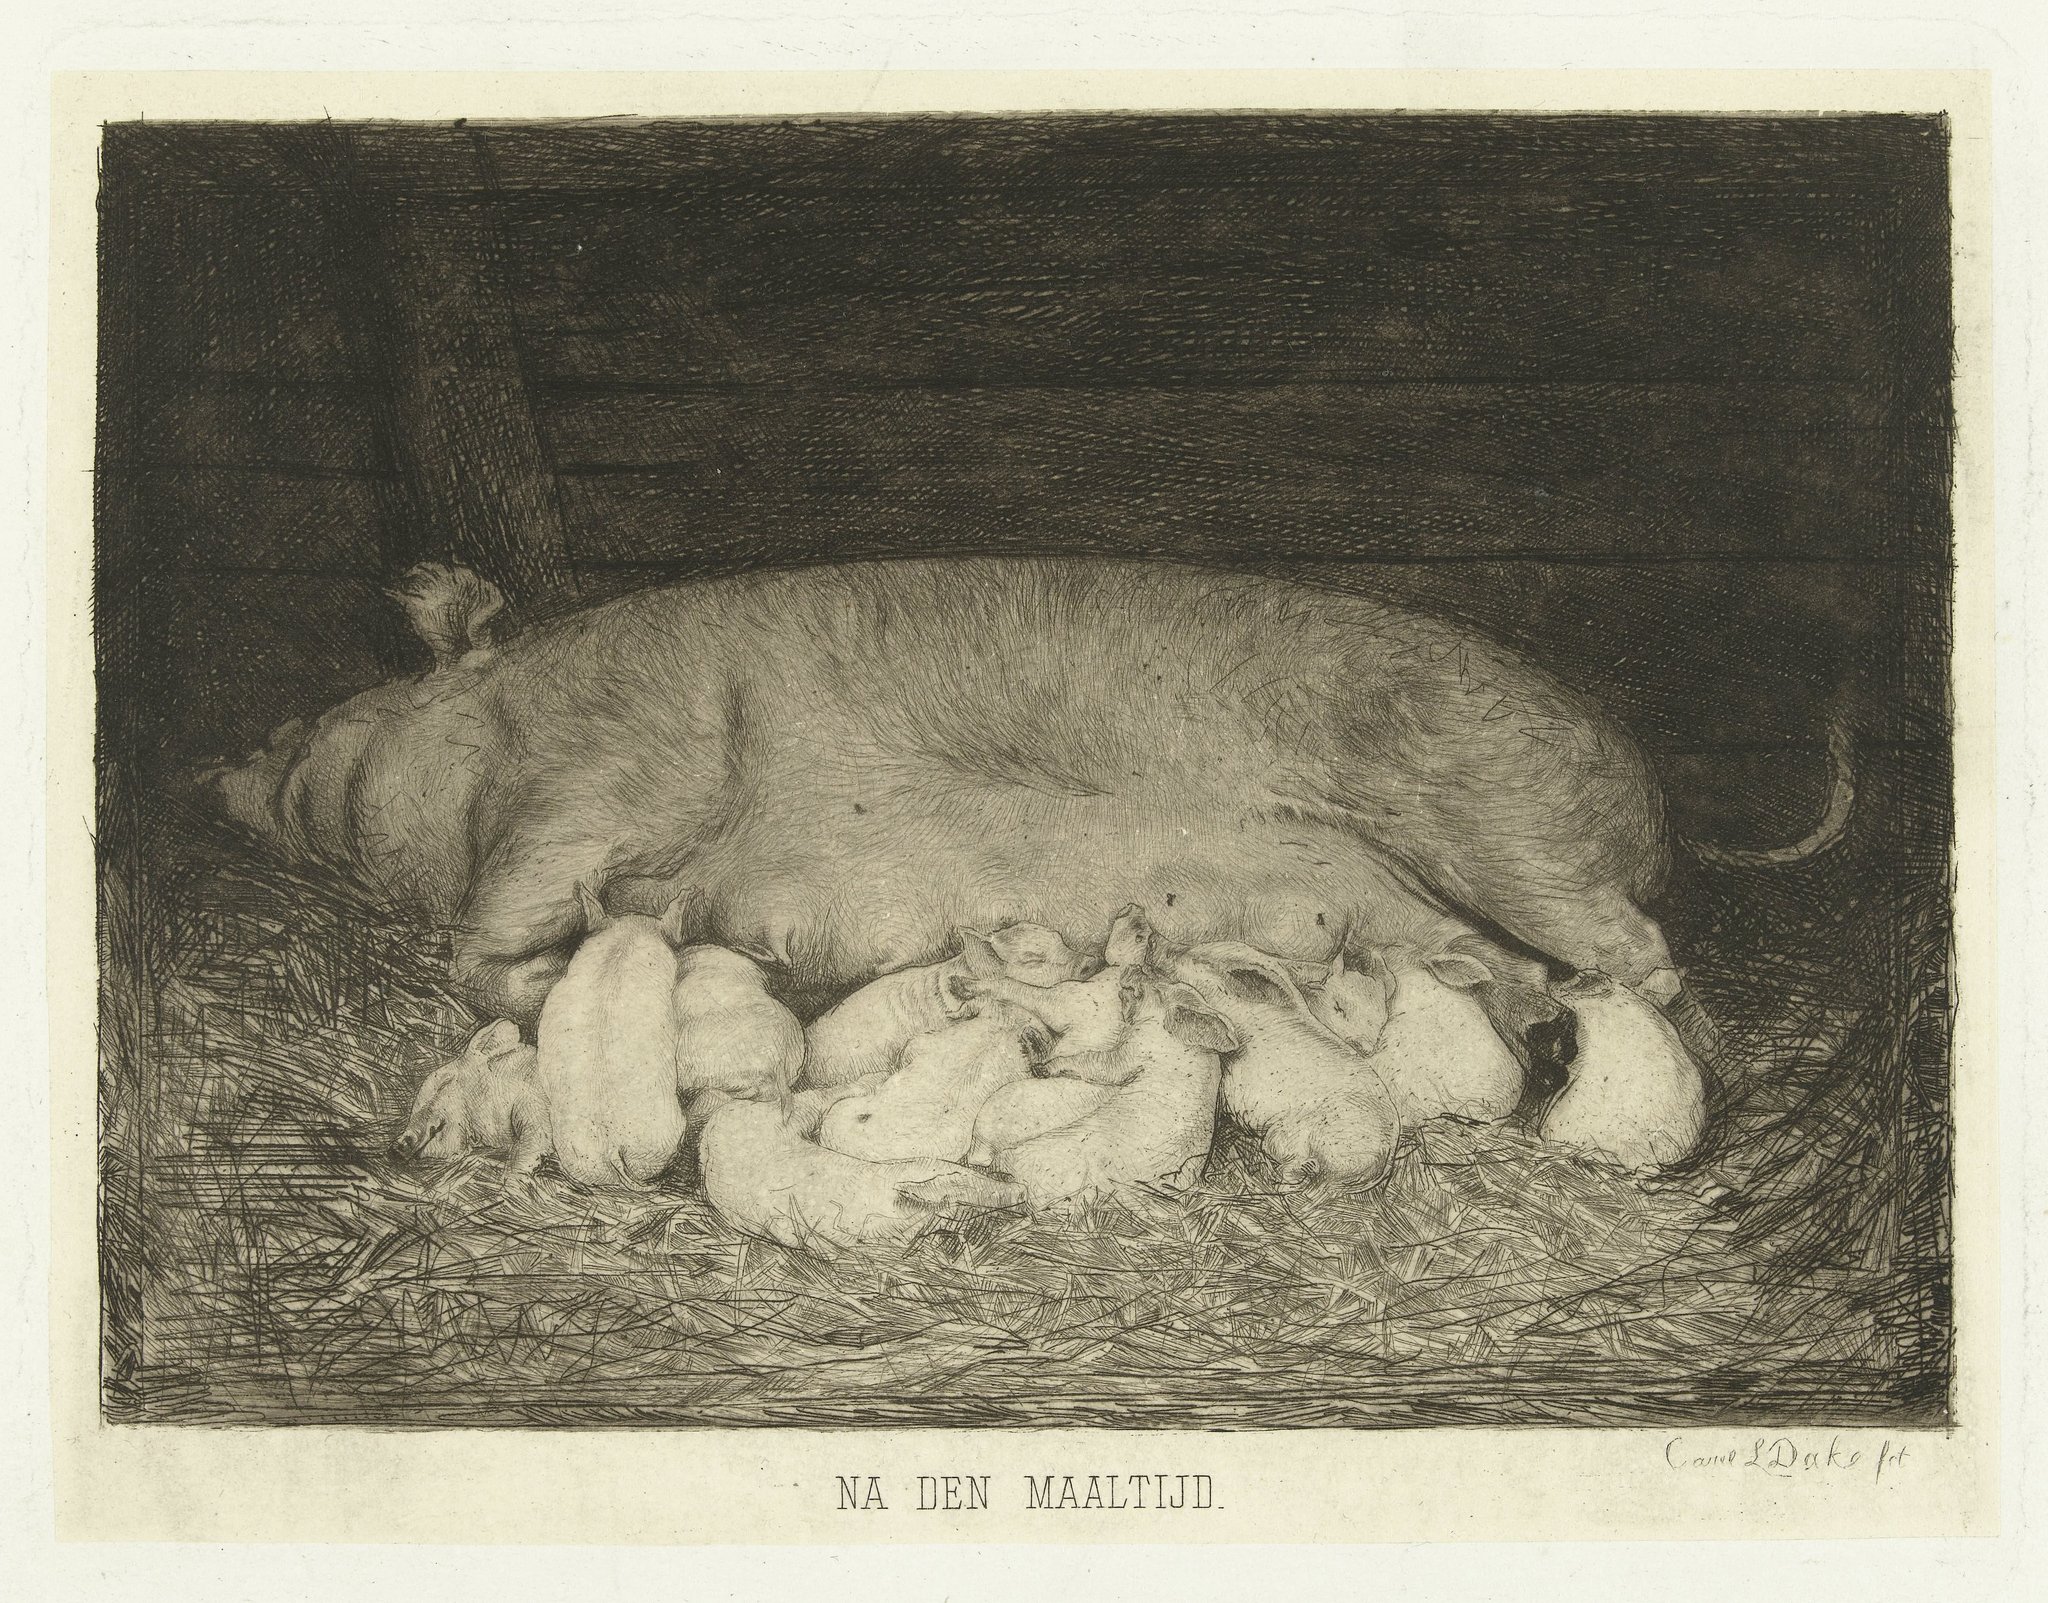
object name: print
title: Zeug met biggen liggend in stal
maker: carel lodewijk dake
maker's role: draughtsman, painter, print maker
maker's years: 1857-1918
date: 1867-1886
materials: paper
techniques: drypoint, etching, intaglio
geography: amsterdam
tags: sow, piglet, suckling pig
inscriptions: collector's mark: Lugt 2228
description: Andere staat gebruikt voor: C. Vosmaer (red.), De distel, etsen van Nederlandsche schilders, 3 delen, Amsterdam 1886, deel I